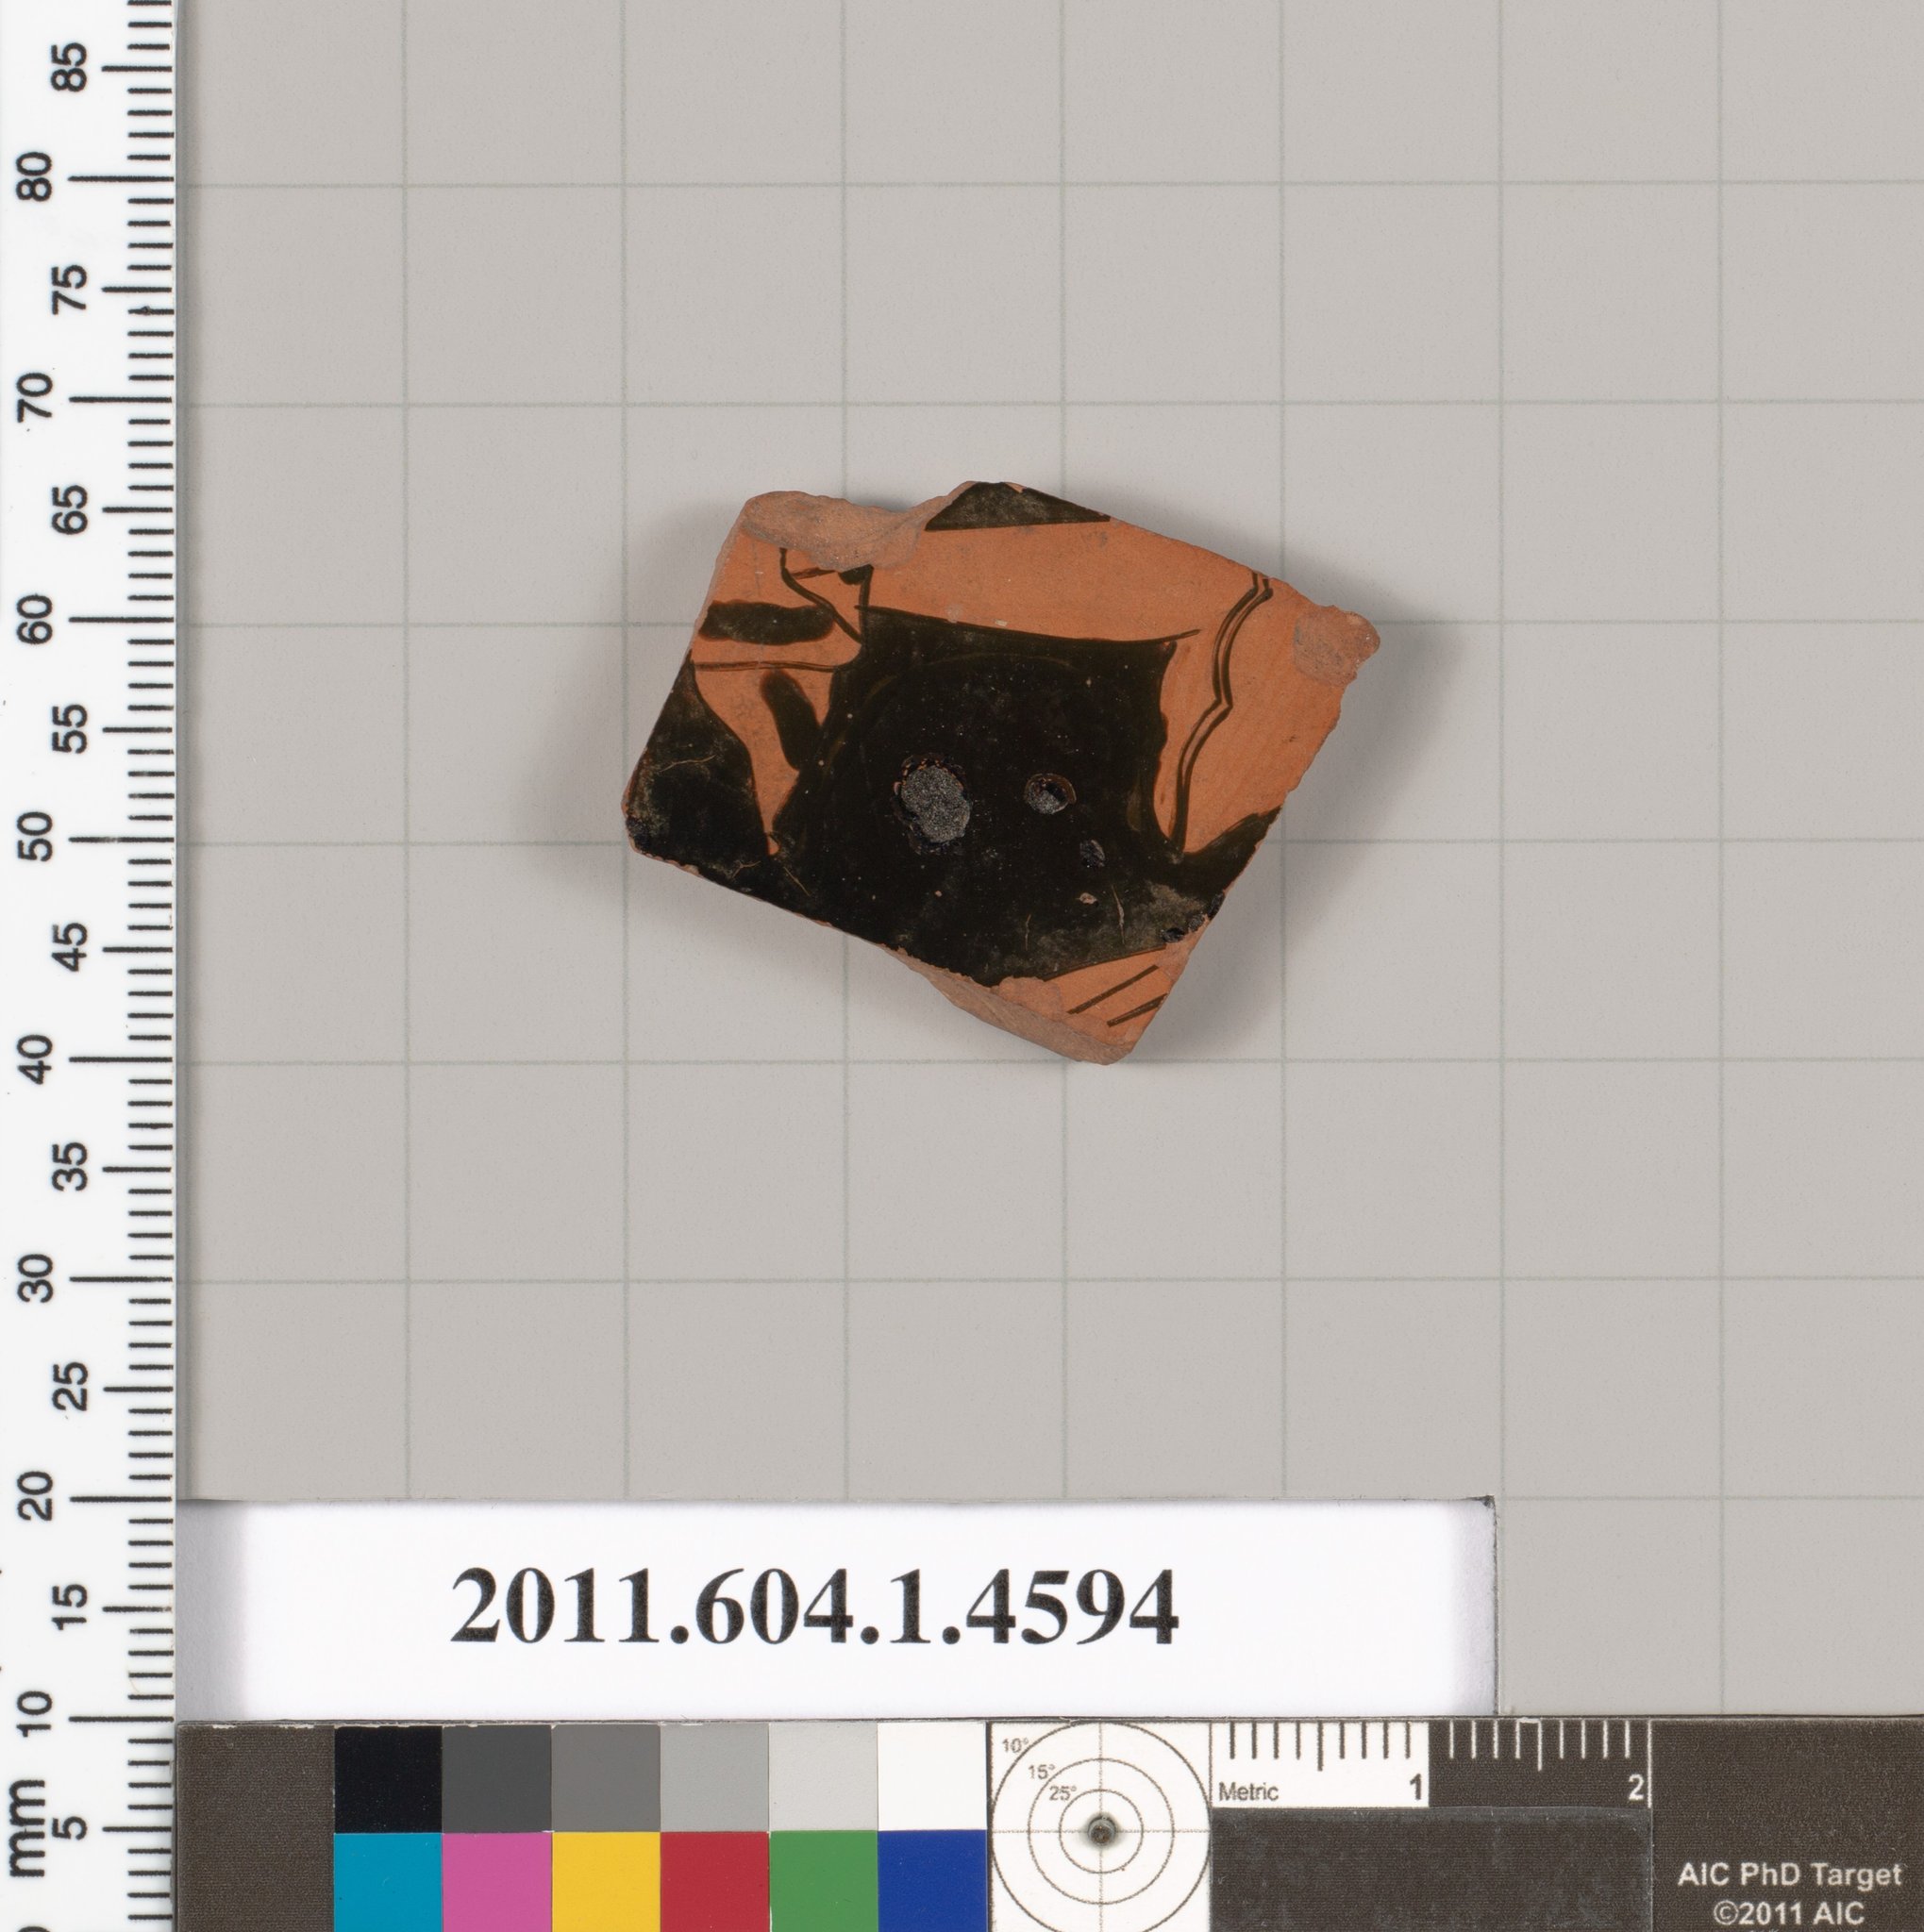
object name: kylix fragment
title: Terracotta fragment of a kylix (drinking cup)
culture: greek, attic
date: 490-470 BCE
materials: terracotta